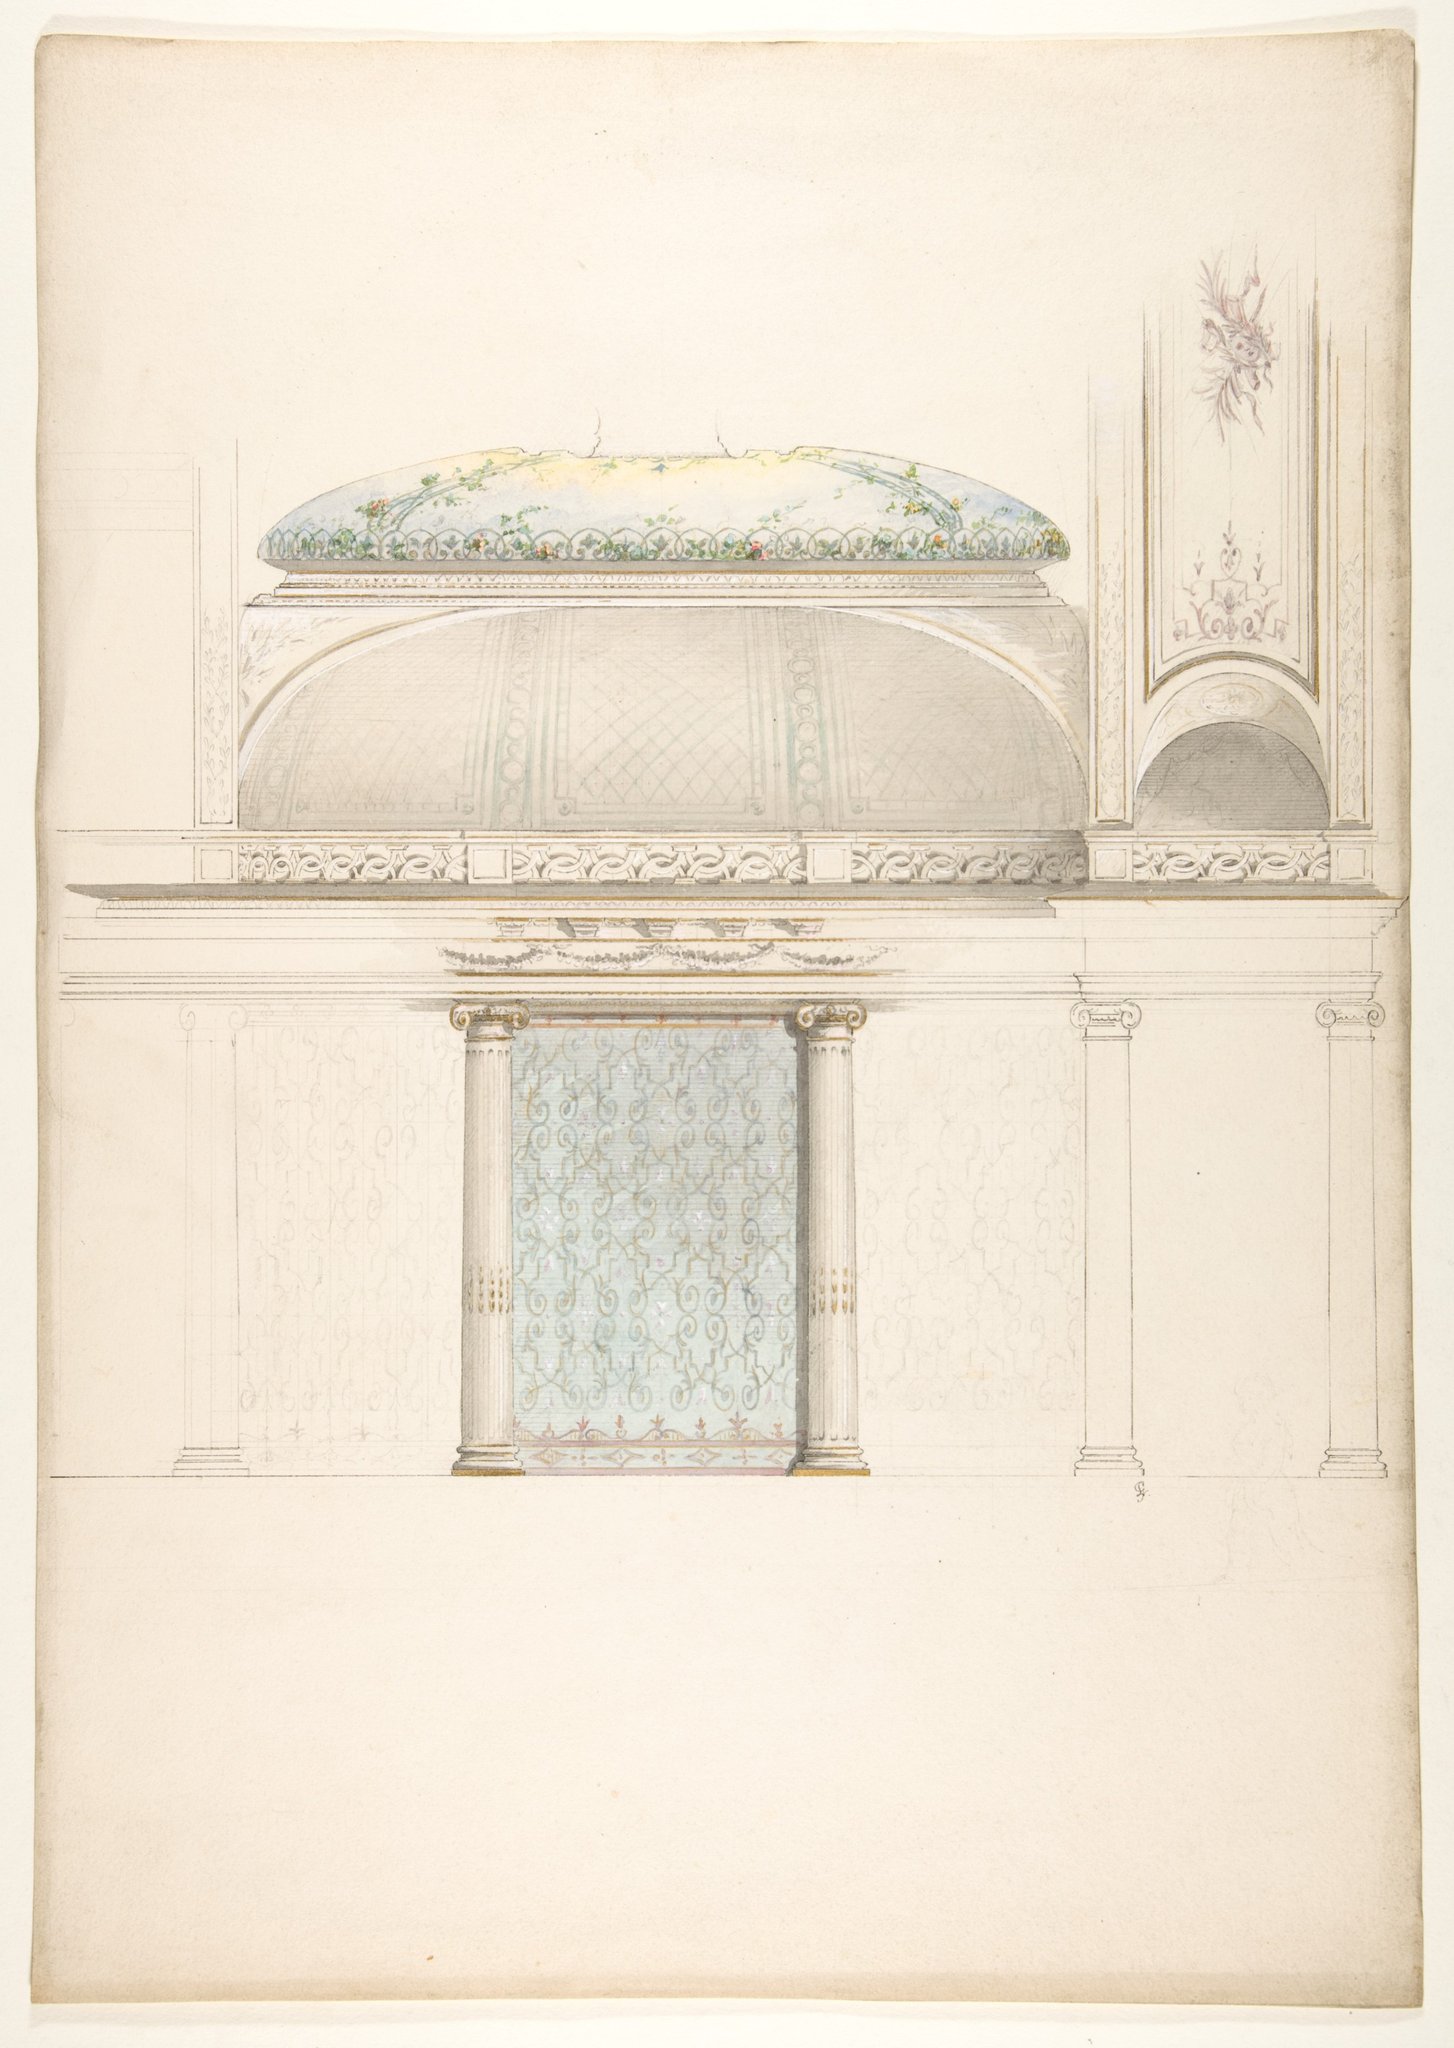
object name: drawing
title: Elevation and transverse section of a domed and colonnaded hall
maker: jules-edmond-charles lachaise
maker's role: artist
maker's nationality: french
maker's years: 1897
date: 1851-1900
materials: gold paint, graphite, watercolor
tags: architecture